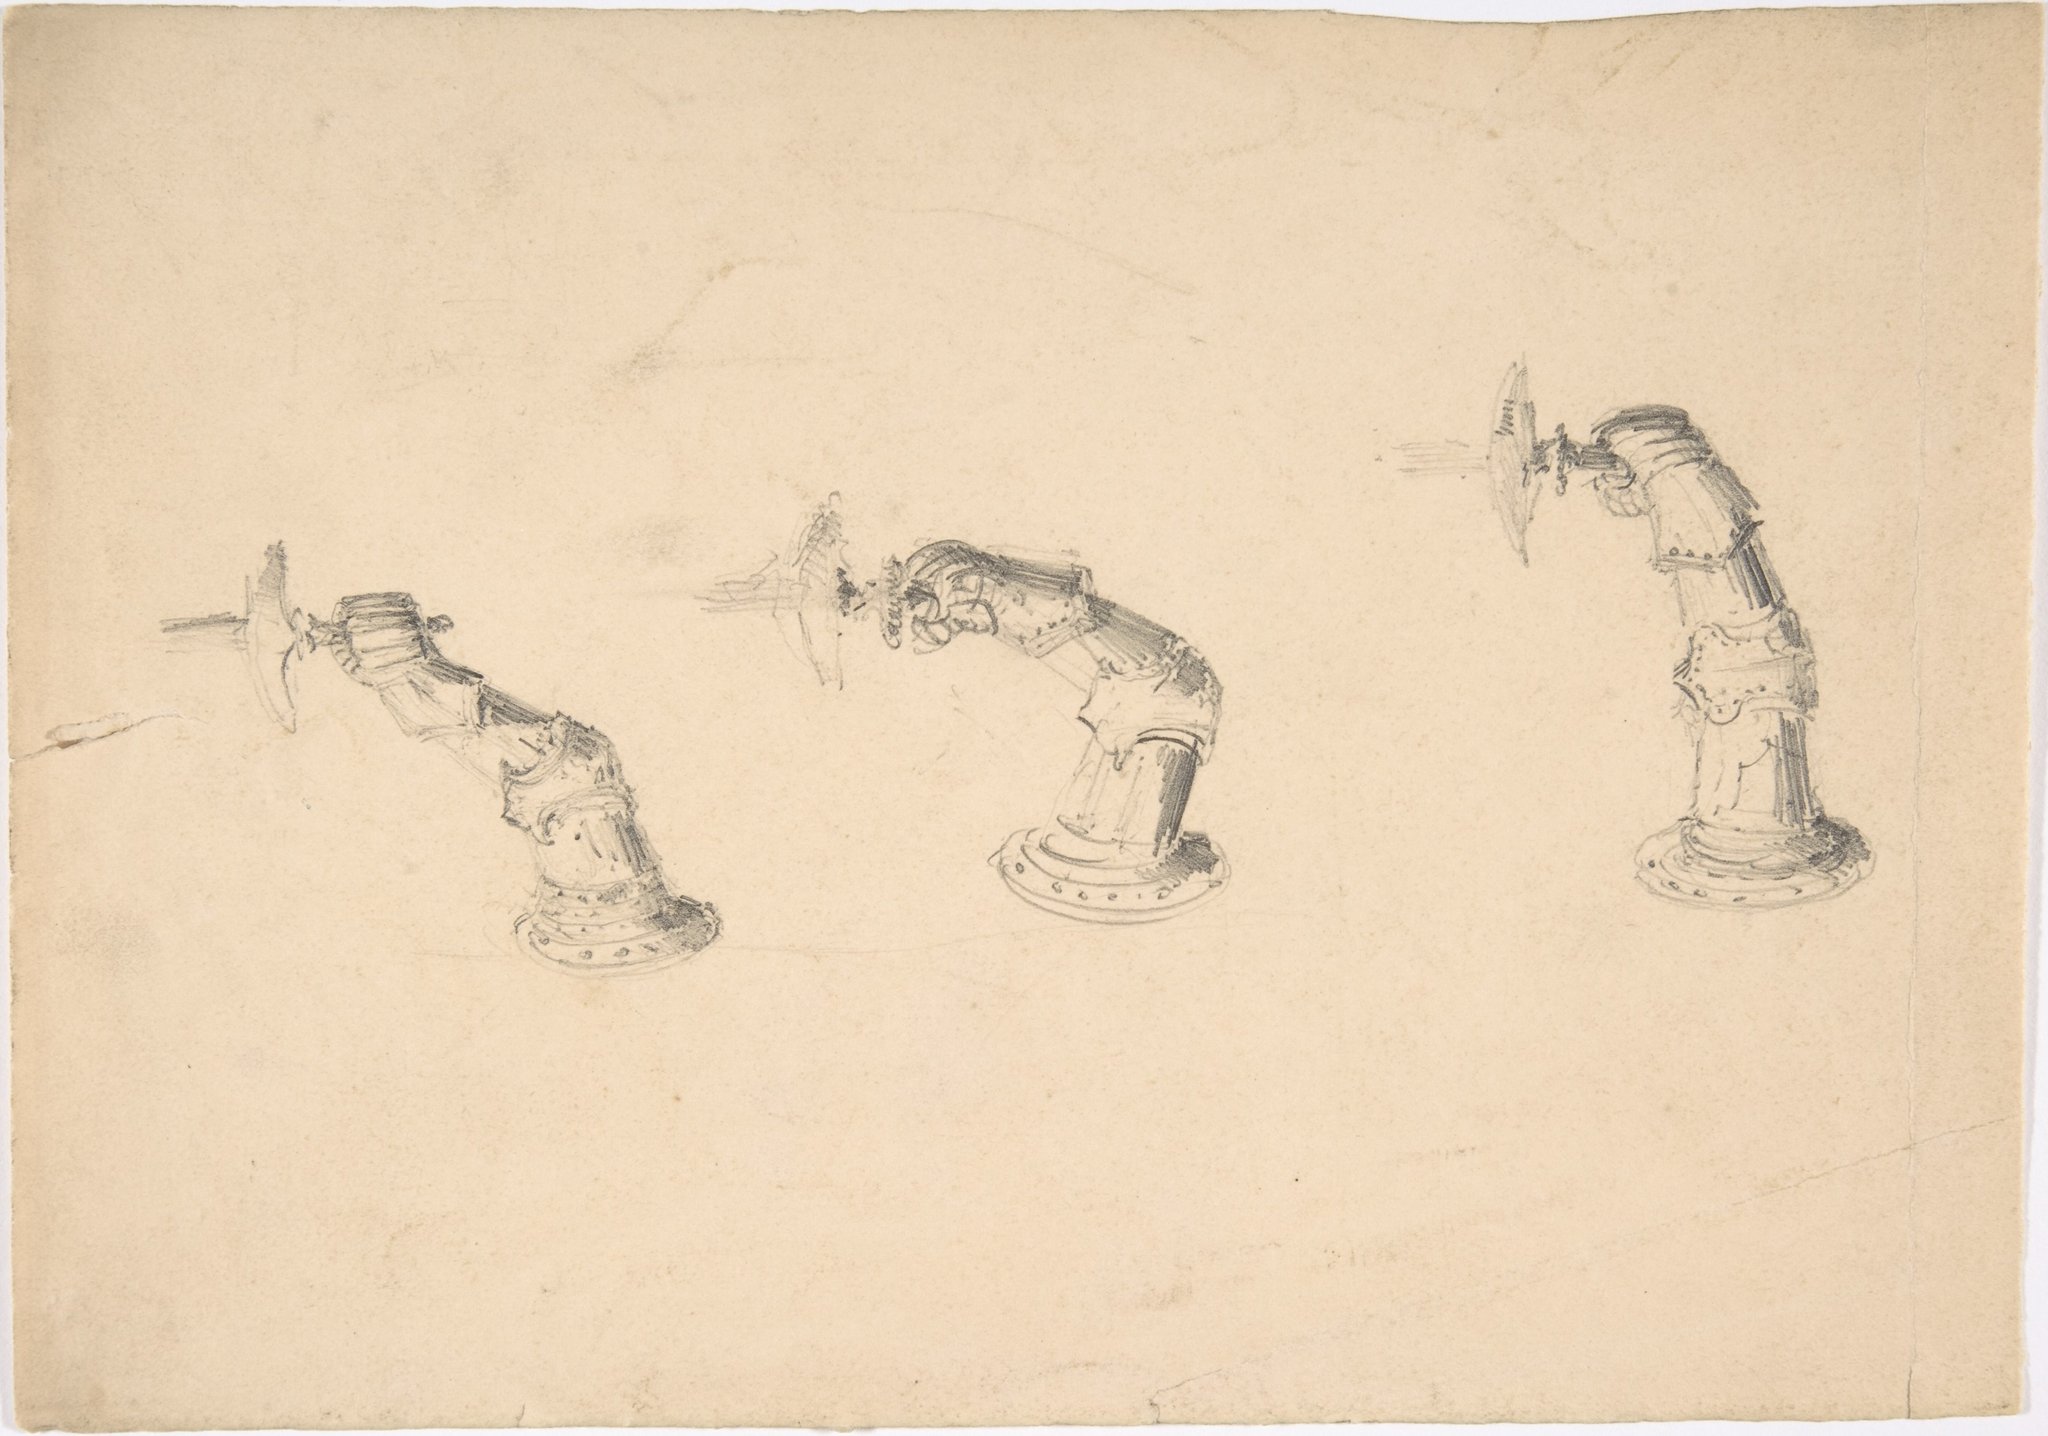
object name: drawing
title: Three Wall Lights Composed out of Armor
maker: anonymous, british, 19th century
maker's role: artist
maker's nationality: british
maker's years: 1800-1900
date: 1801-1833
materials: graphite